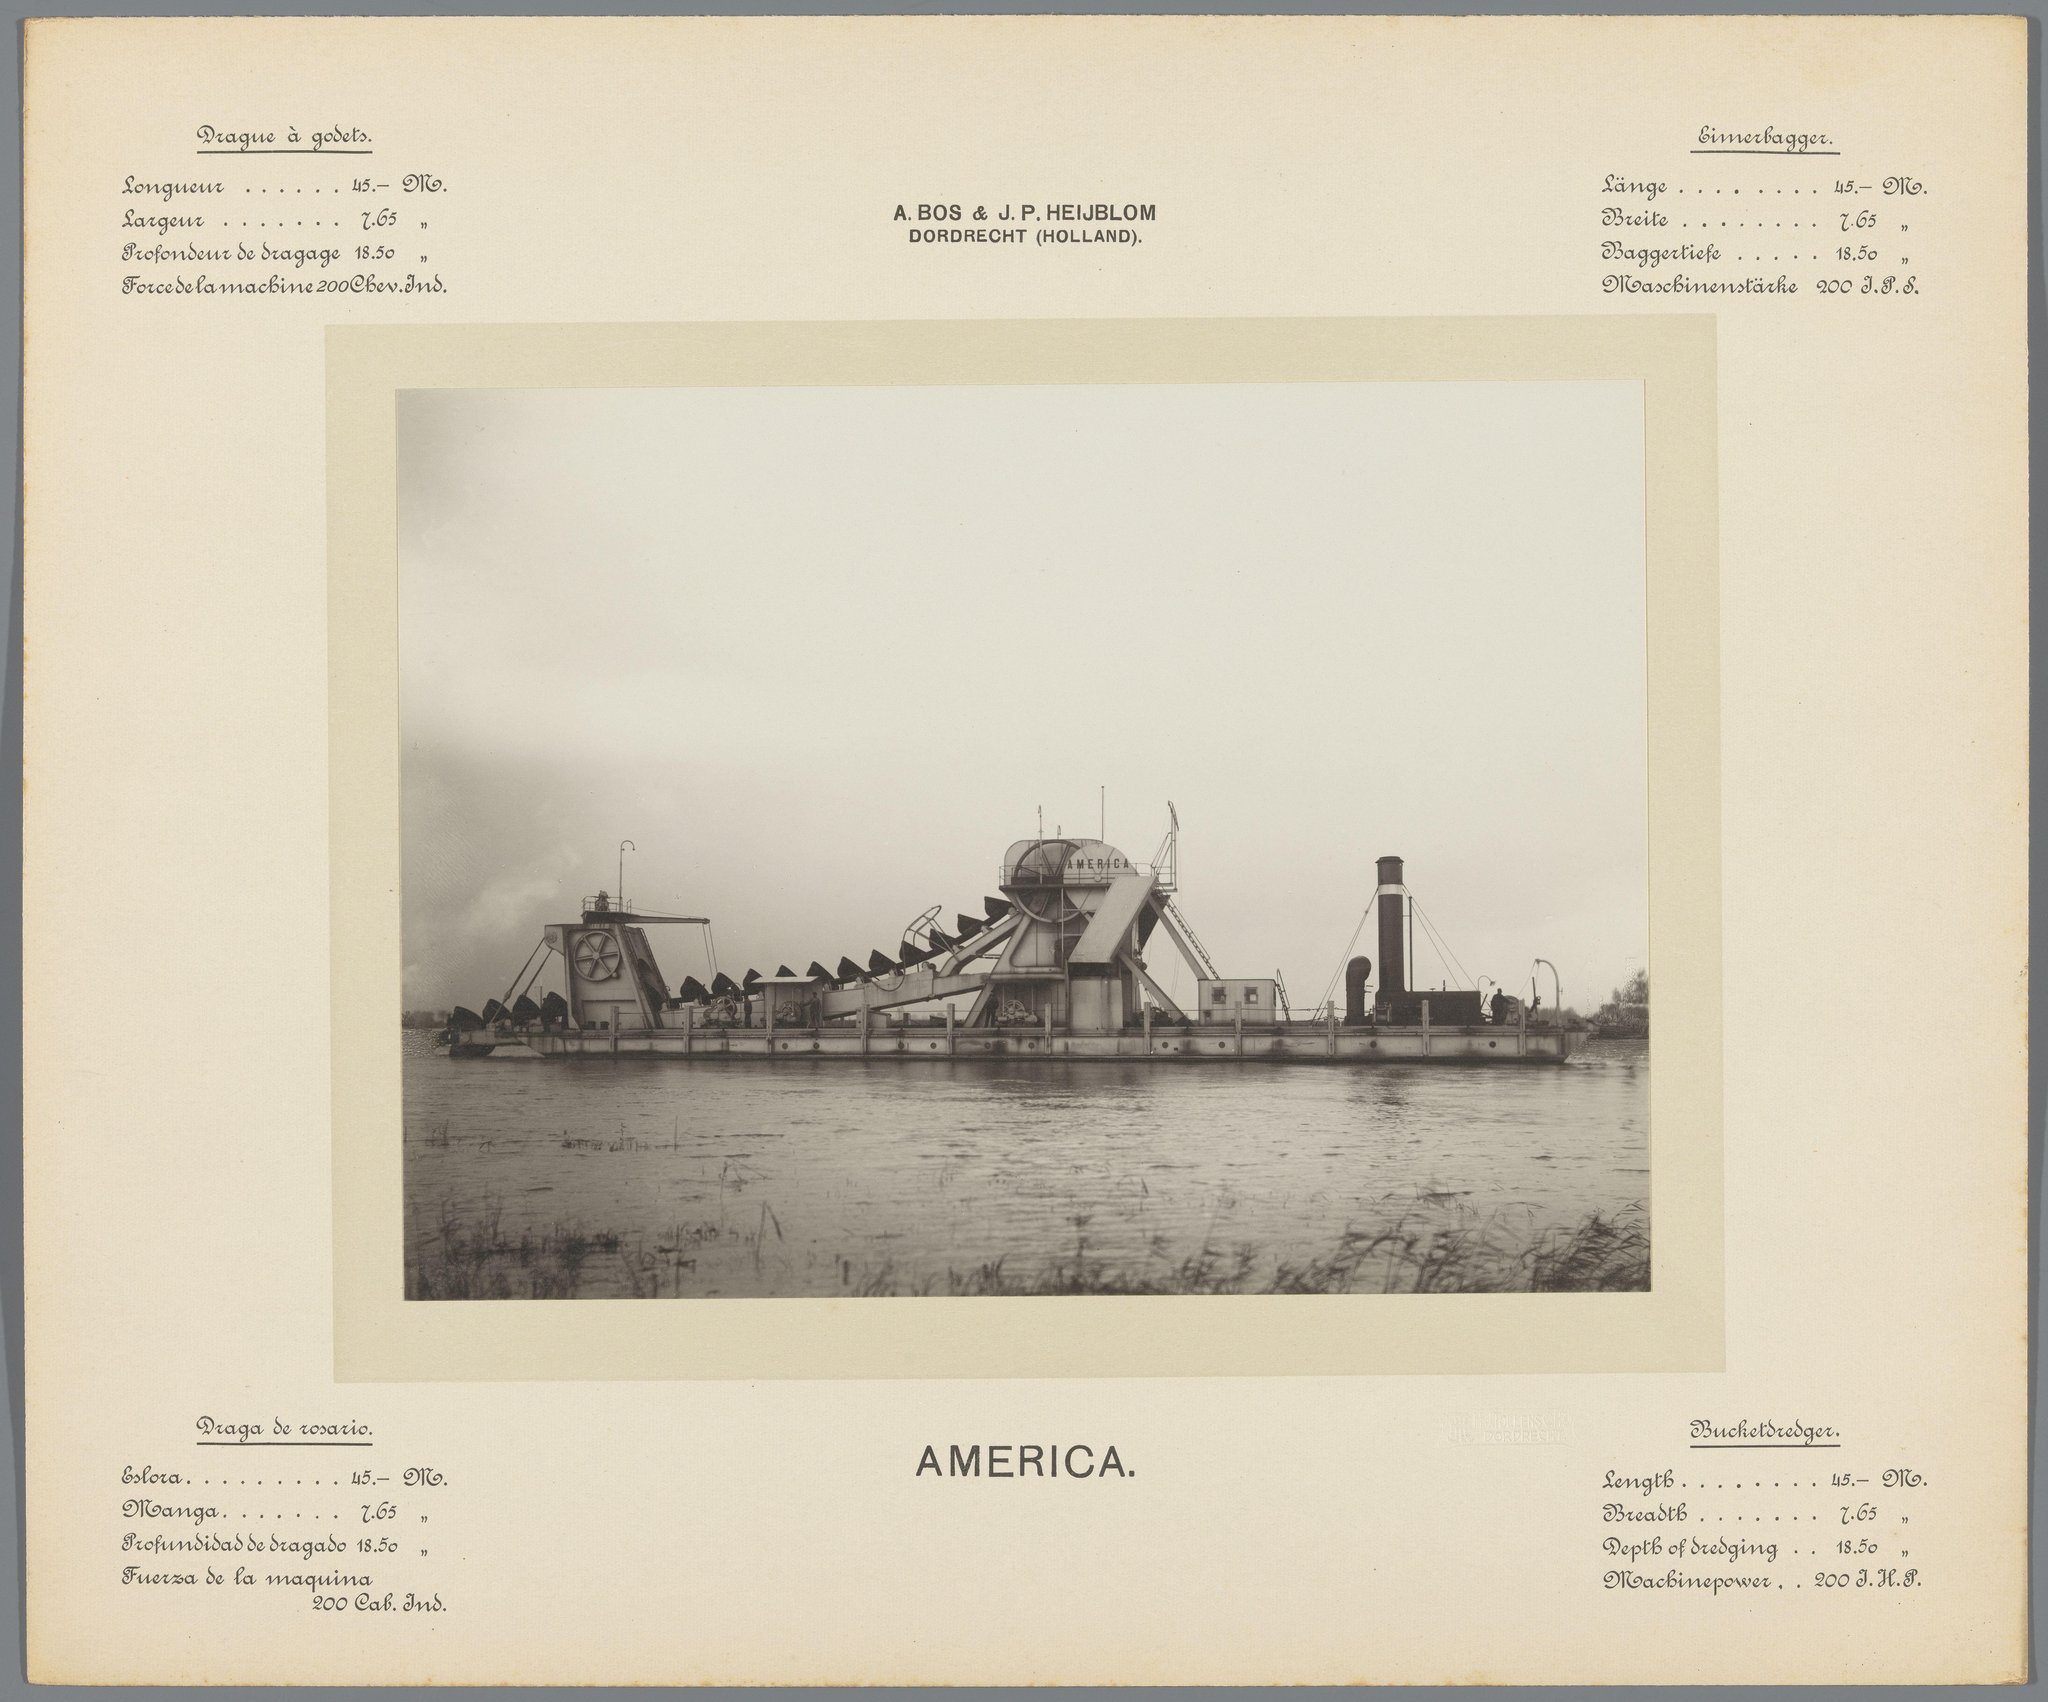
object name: photograph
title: America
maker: henricus jacobus tollens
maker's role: painter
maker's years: 1864-1936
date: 1900-1910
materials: cardboard, photographic support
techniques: gelatin silver print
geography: dordrecht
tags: machine driven by steam, steamship, motorship (+ propulsion of vehicle, ship, etc. by steam), dredge, dredging machine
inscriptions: name: ‘H.J. Tollens C. Hzn. Dordrecht’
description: Emmerbaggermolen America. Foto geplakt op karton met technische informatie over het schip in Duits, Frans, Spaans en Engels. Onderdeel van de map met 44 foto's van baggerschepen van de firma A. Bos & J.P. Heijblom te Dordrecht.